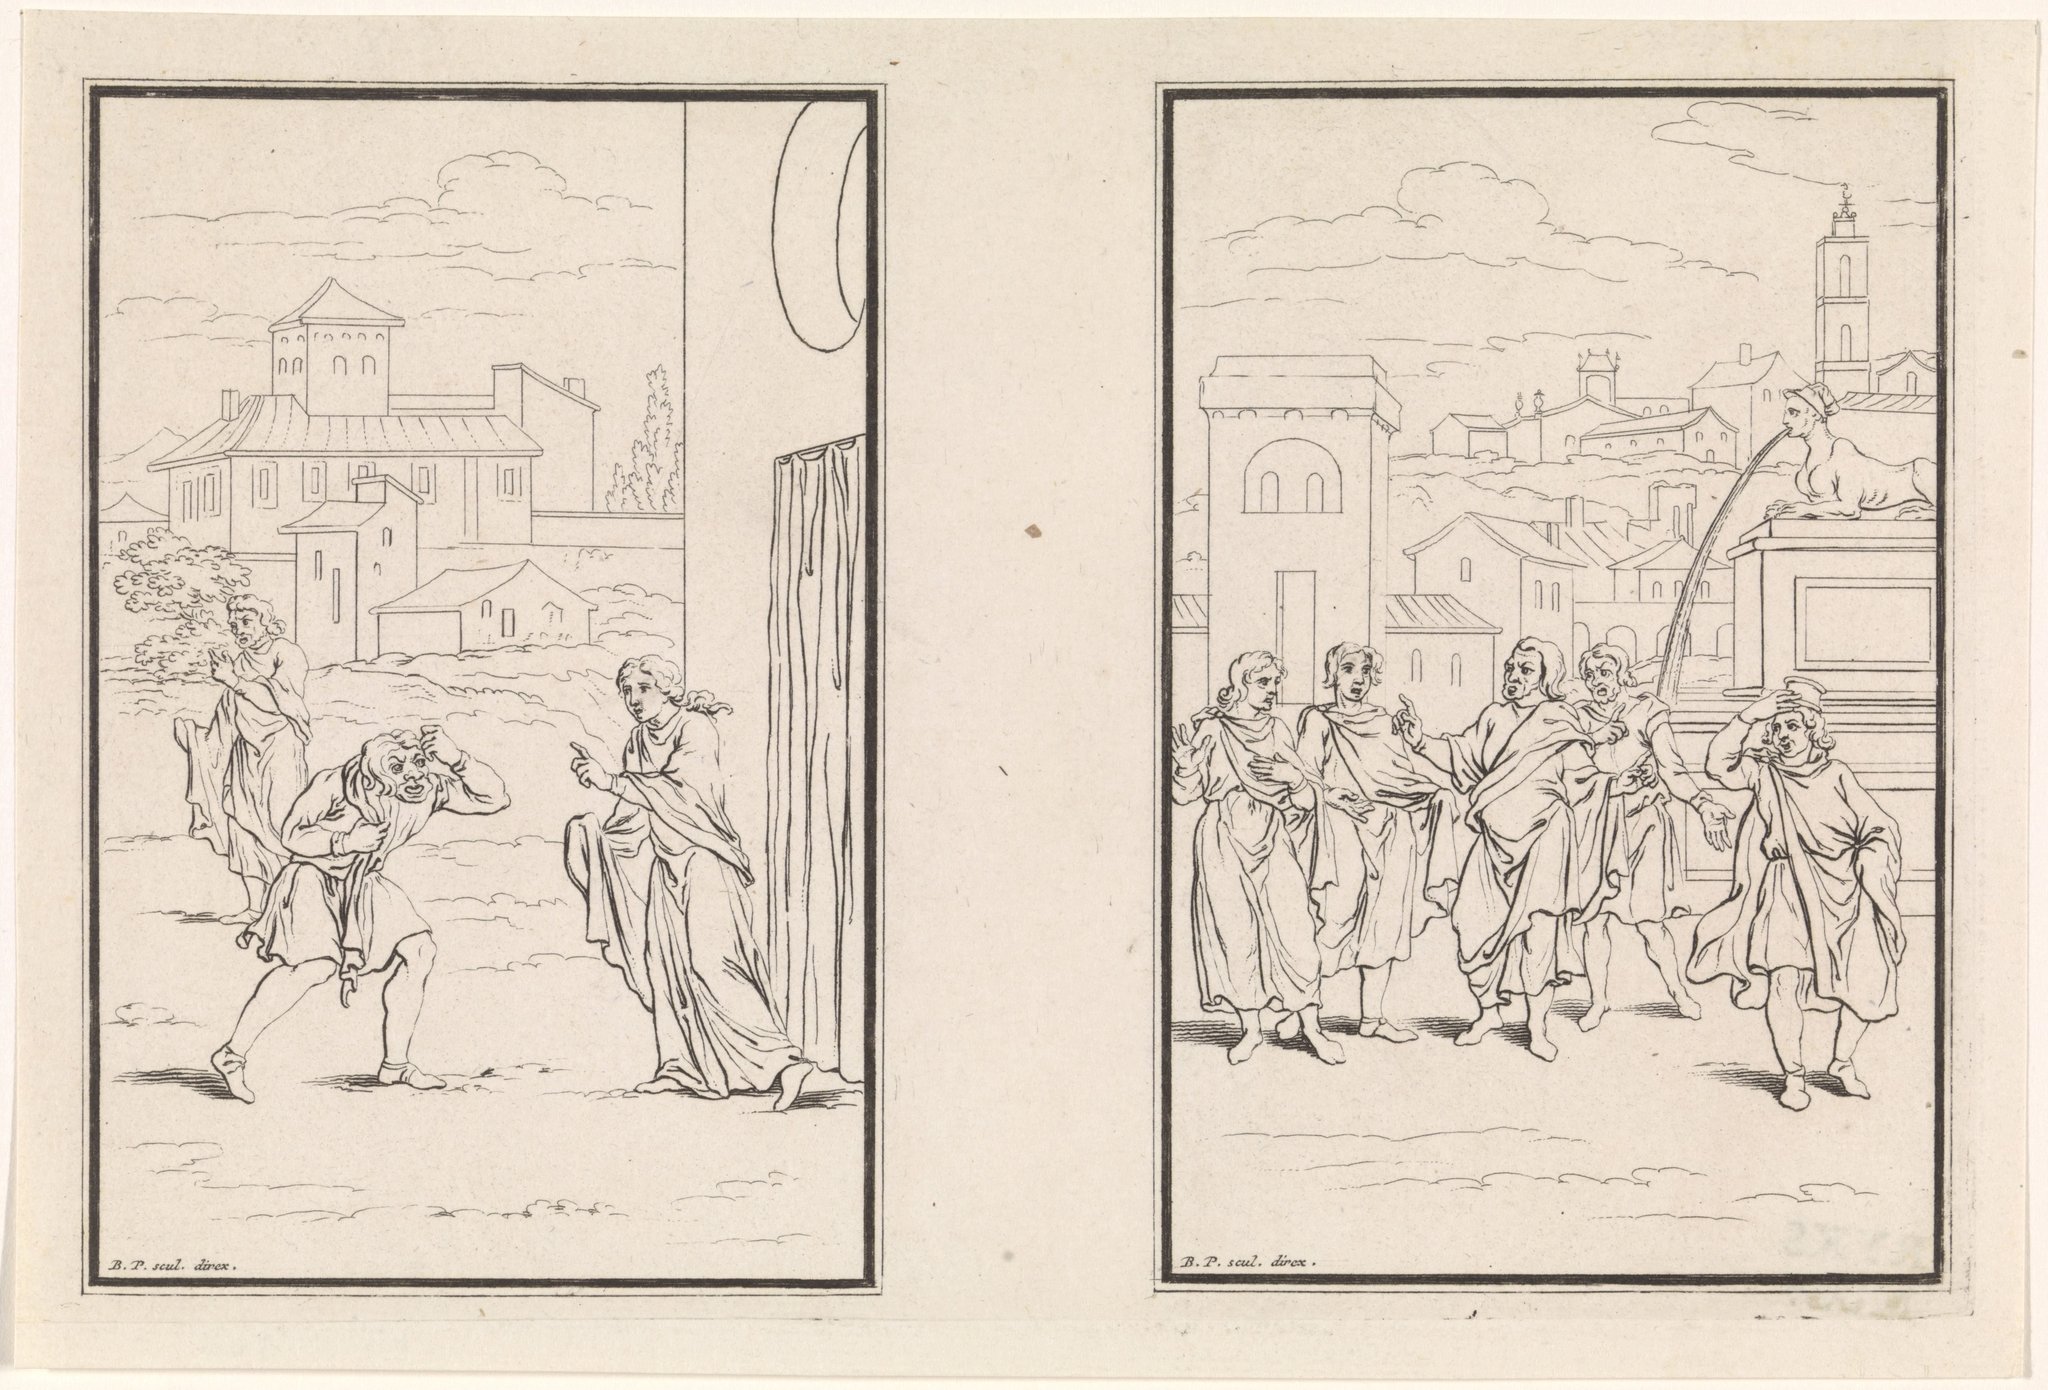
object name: print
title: Twee scènes uit de komedie Eunuchus van Terentius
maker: bernard picart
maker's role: draughtsman, print maker, publisher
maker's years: 1673-1733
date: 1716-1718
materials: paper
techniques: engraving, etching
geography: amsterdam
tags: specific works of literature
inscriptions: collector's mark: Lugt 2165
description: Definitieve staat van deze prenten ook gebruikt als illustratie in: Terentius, Publius. Les comedies de Terence: avec la traduction et les remarques, deel I, na p. 476 en na p. 500. [Geannoteerd door] Anne Dacier. Rotterdam: Caspar Fritsch, 1717.